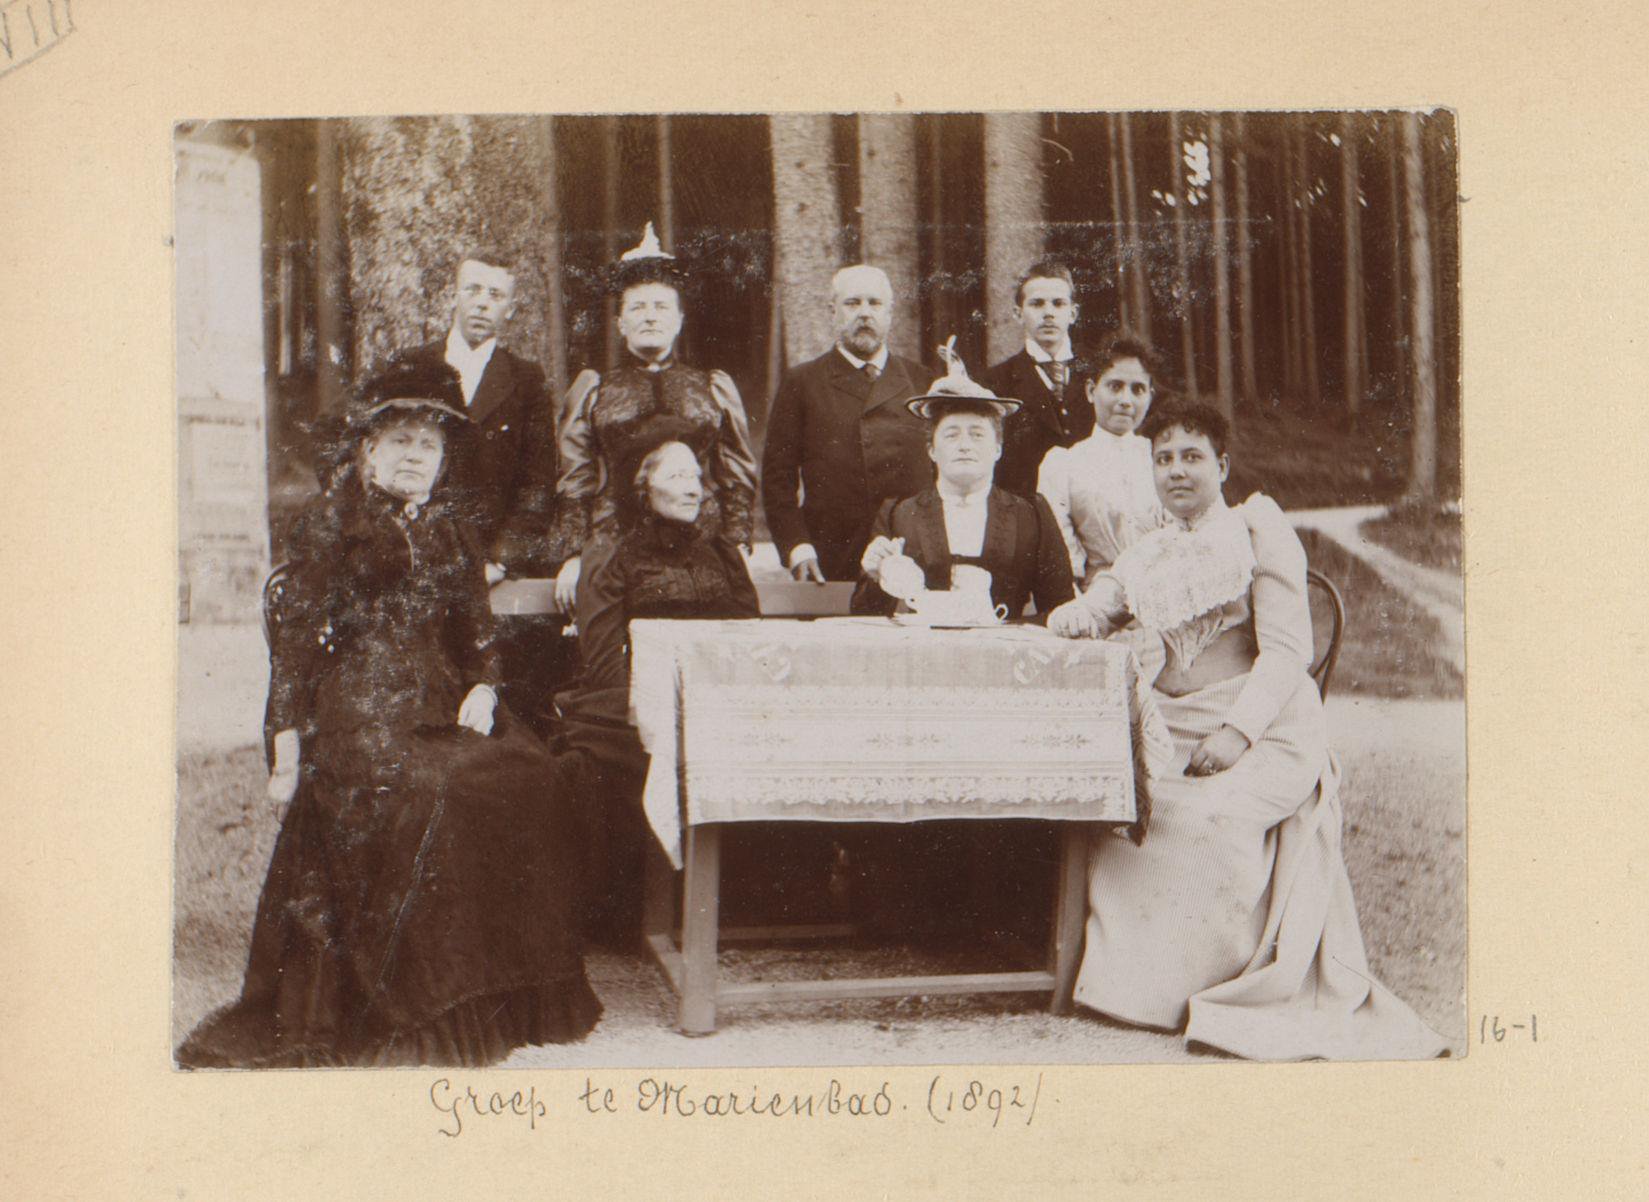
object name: album leaf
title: Groepsportret te Mariënbad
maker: hendrik herman van den berg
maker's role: amateurfotograaf, jurist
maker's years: 1875-1944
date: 1892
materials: paper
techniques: collodion silver print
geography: marienbad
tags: historical persons, marienbad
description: Foto 1 op albumblad 16 uit album "Amsterdam 1890-1894".